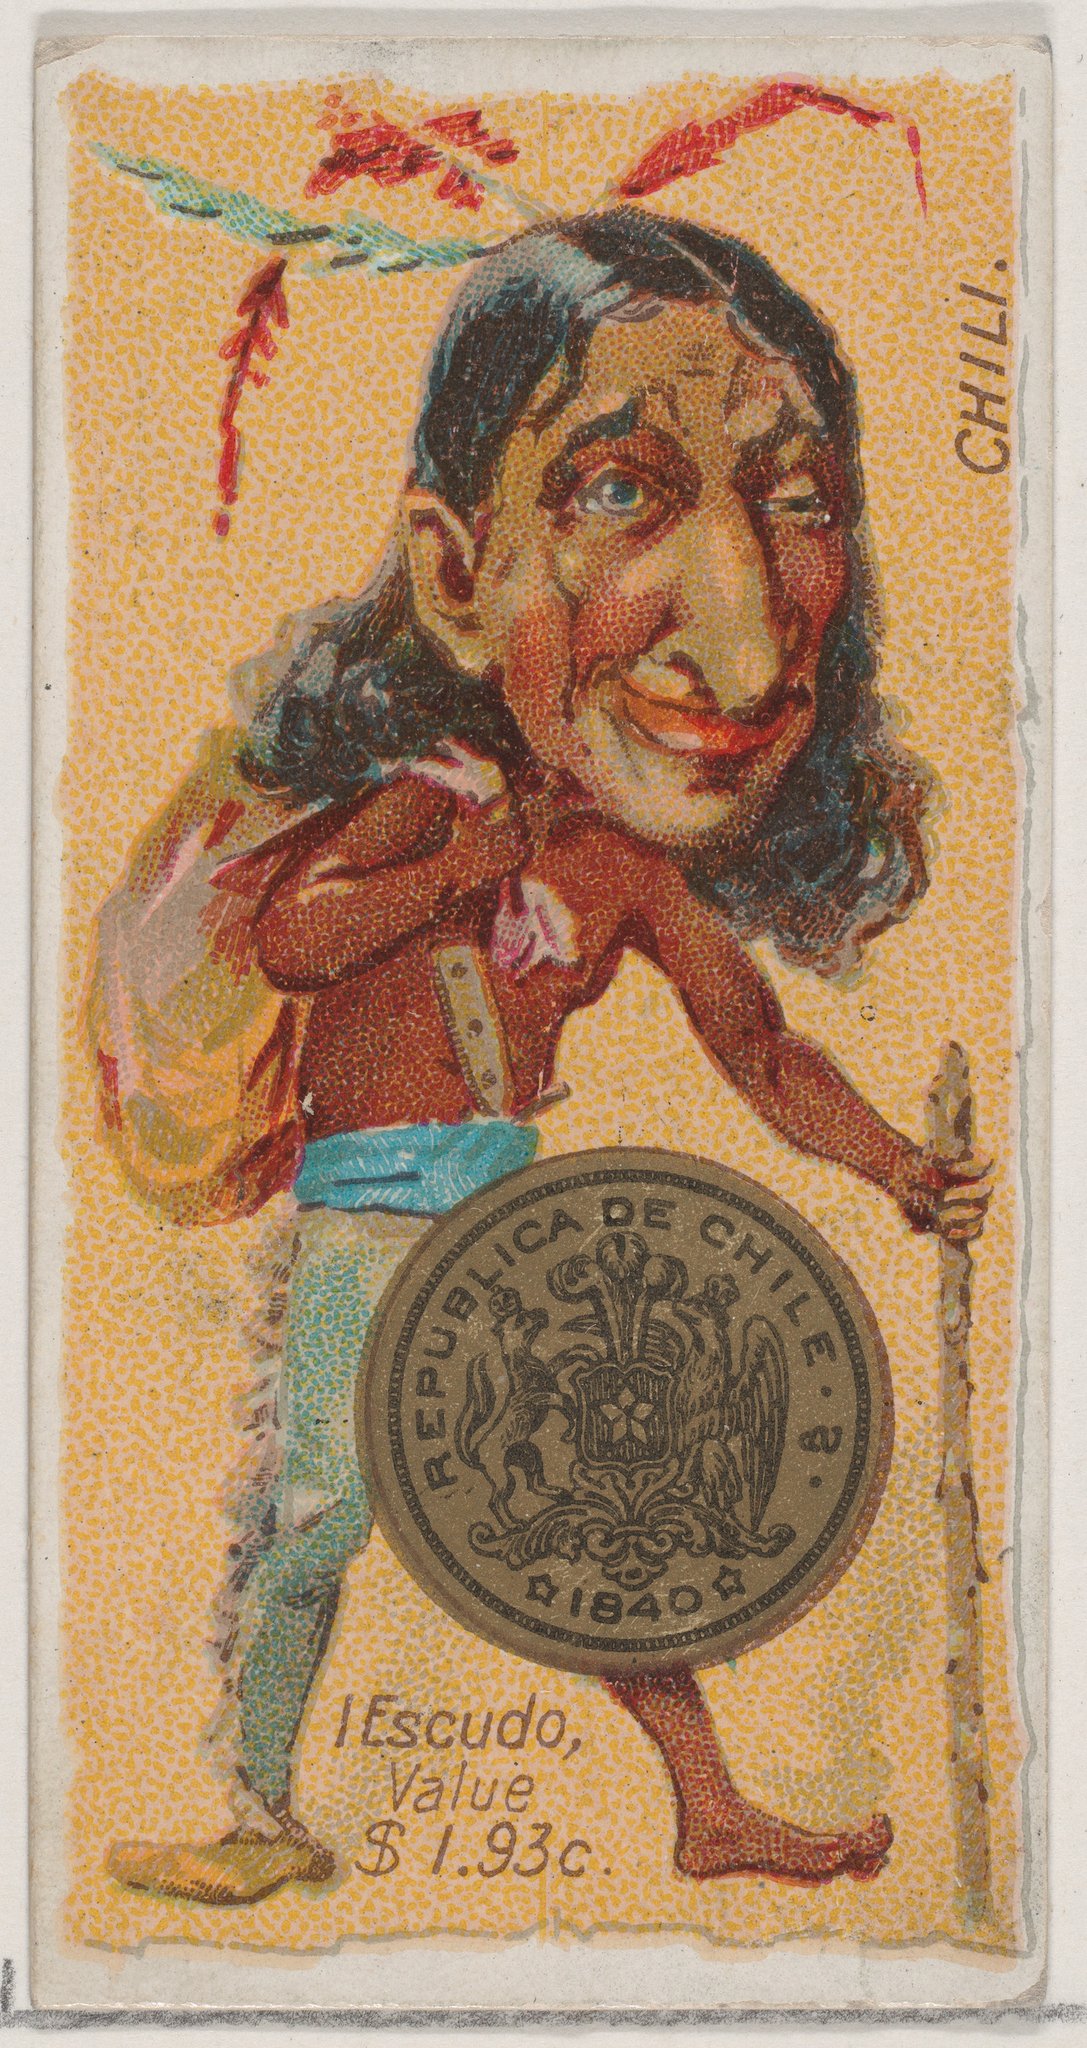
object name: print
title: Caricatured Chilean figure, 1 Escudo, from the series Coins of All Nations (N72, variation 2) for Duke brand cigarettes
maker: w. duke, sons & co.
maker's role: publisher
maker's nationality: american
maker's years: 1870-1920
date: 1889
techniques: color lithograph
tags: men,coins